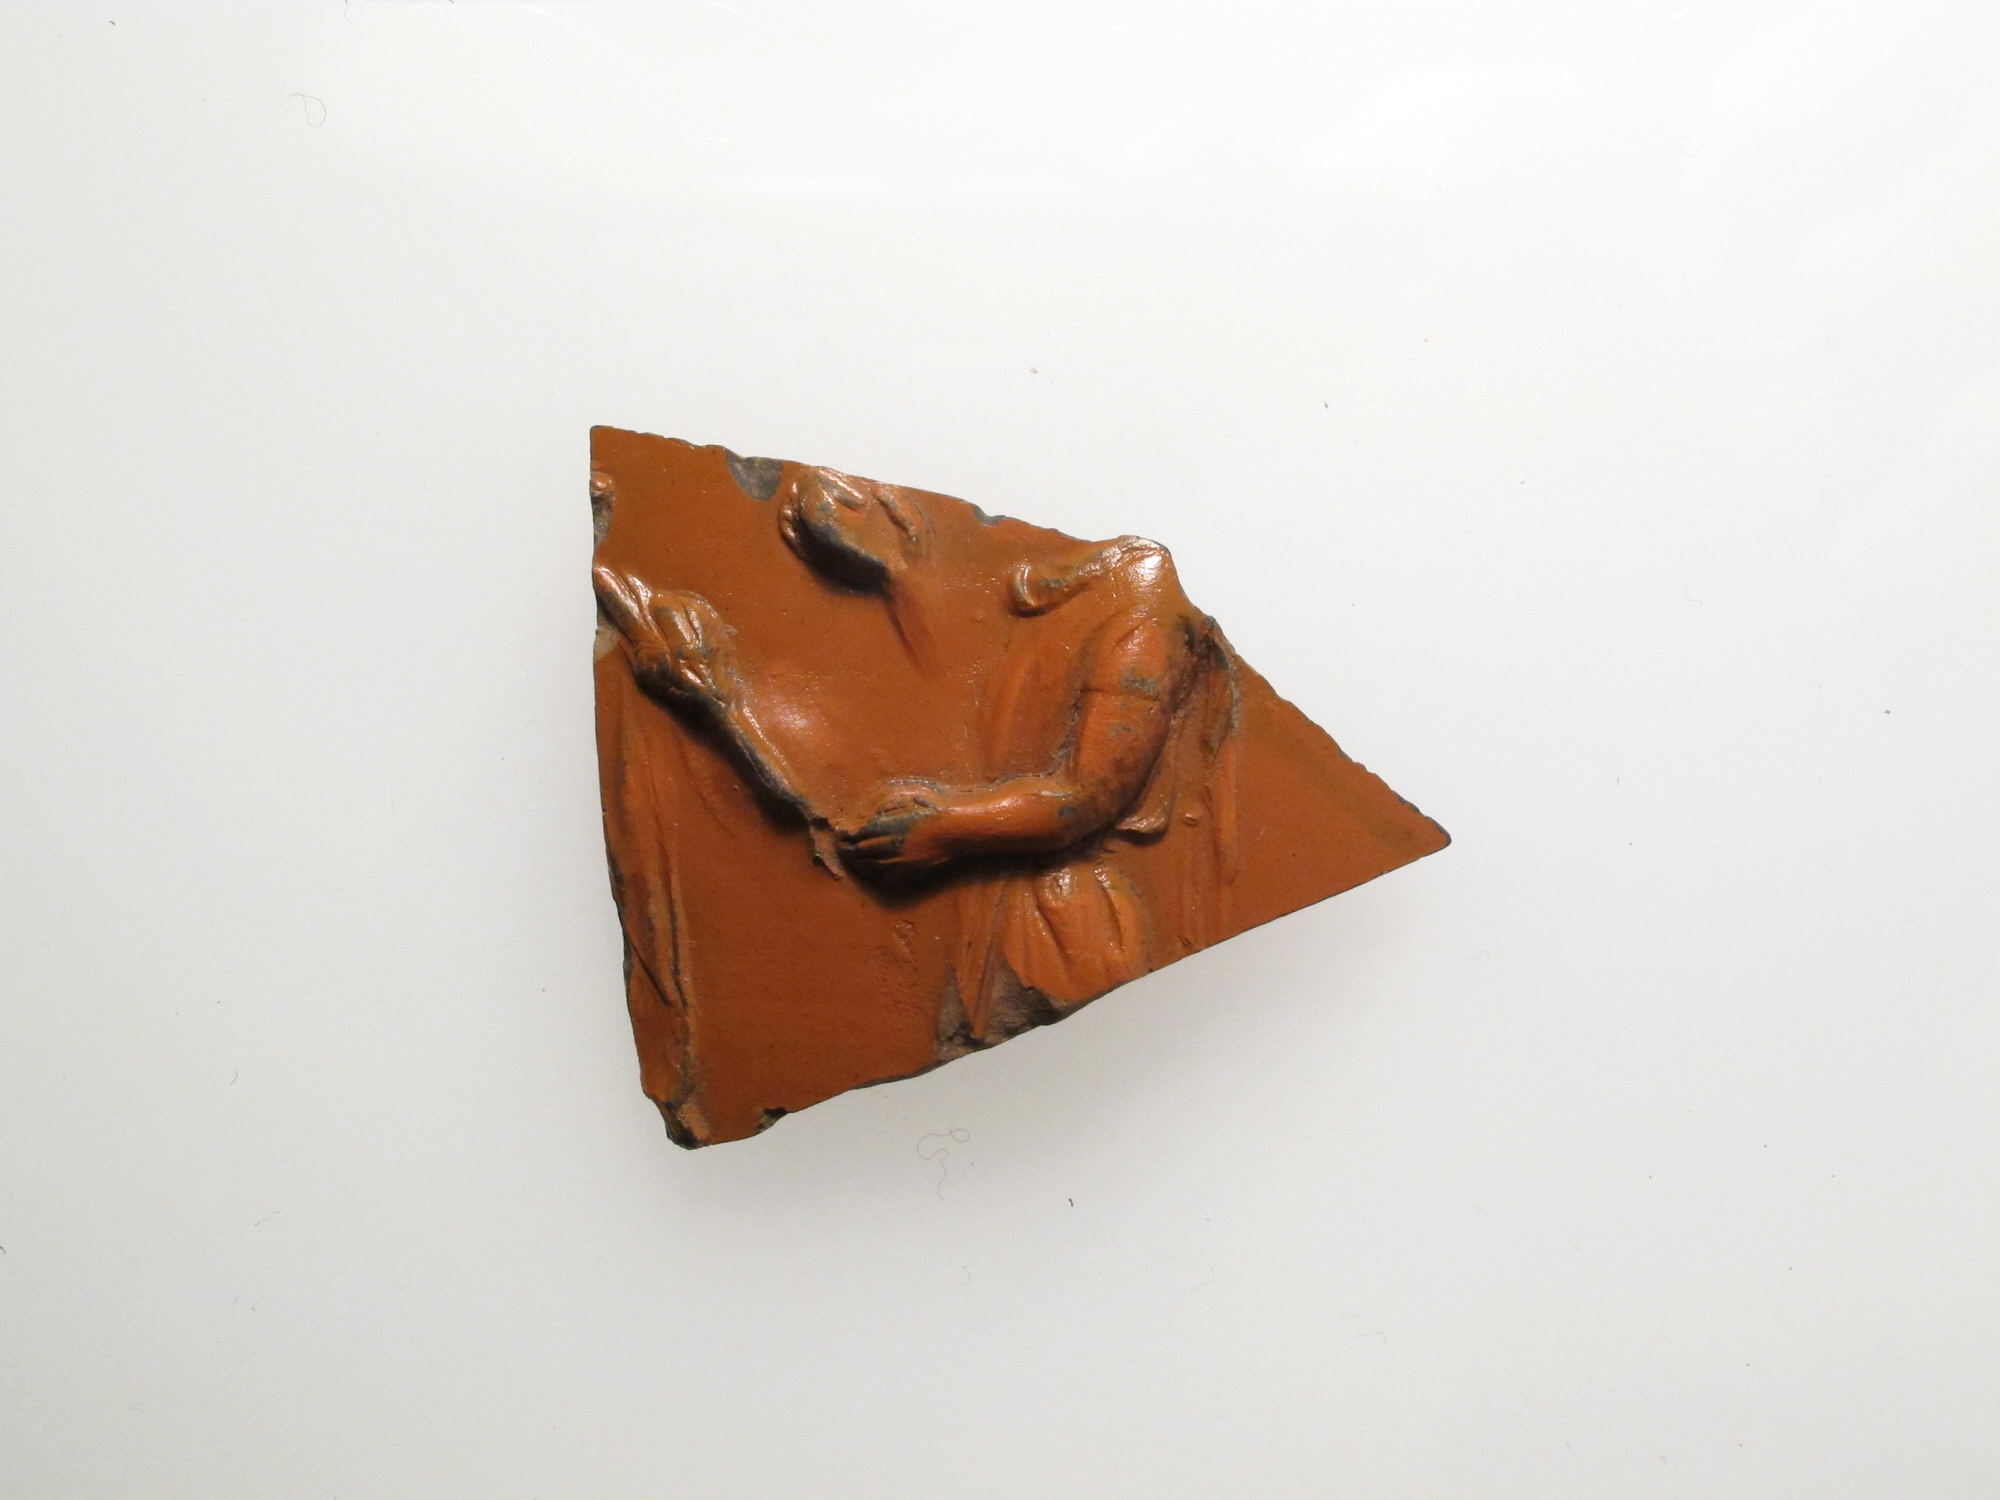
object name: vase fragment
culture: roman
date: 100 BCE-100 CE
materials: terracotta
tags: hands